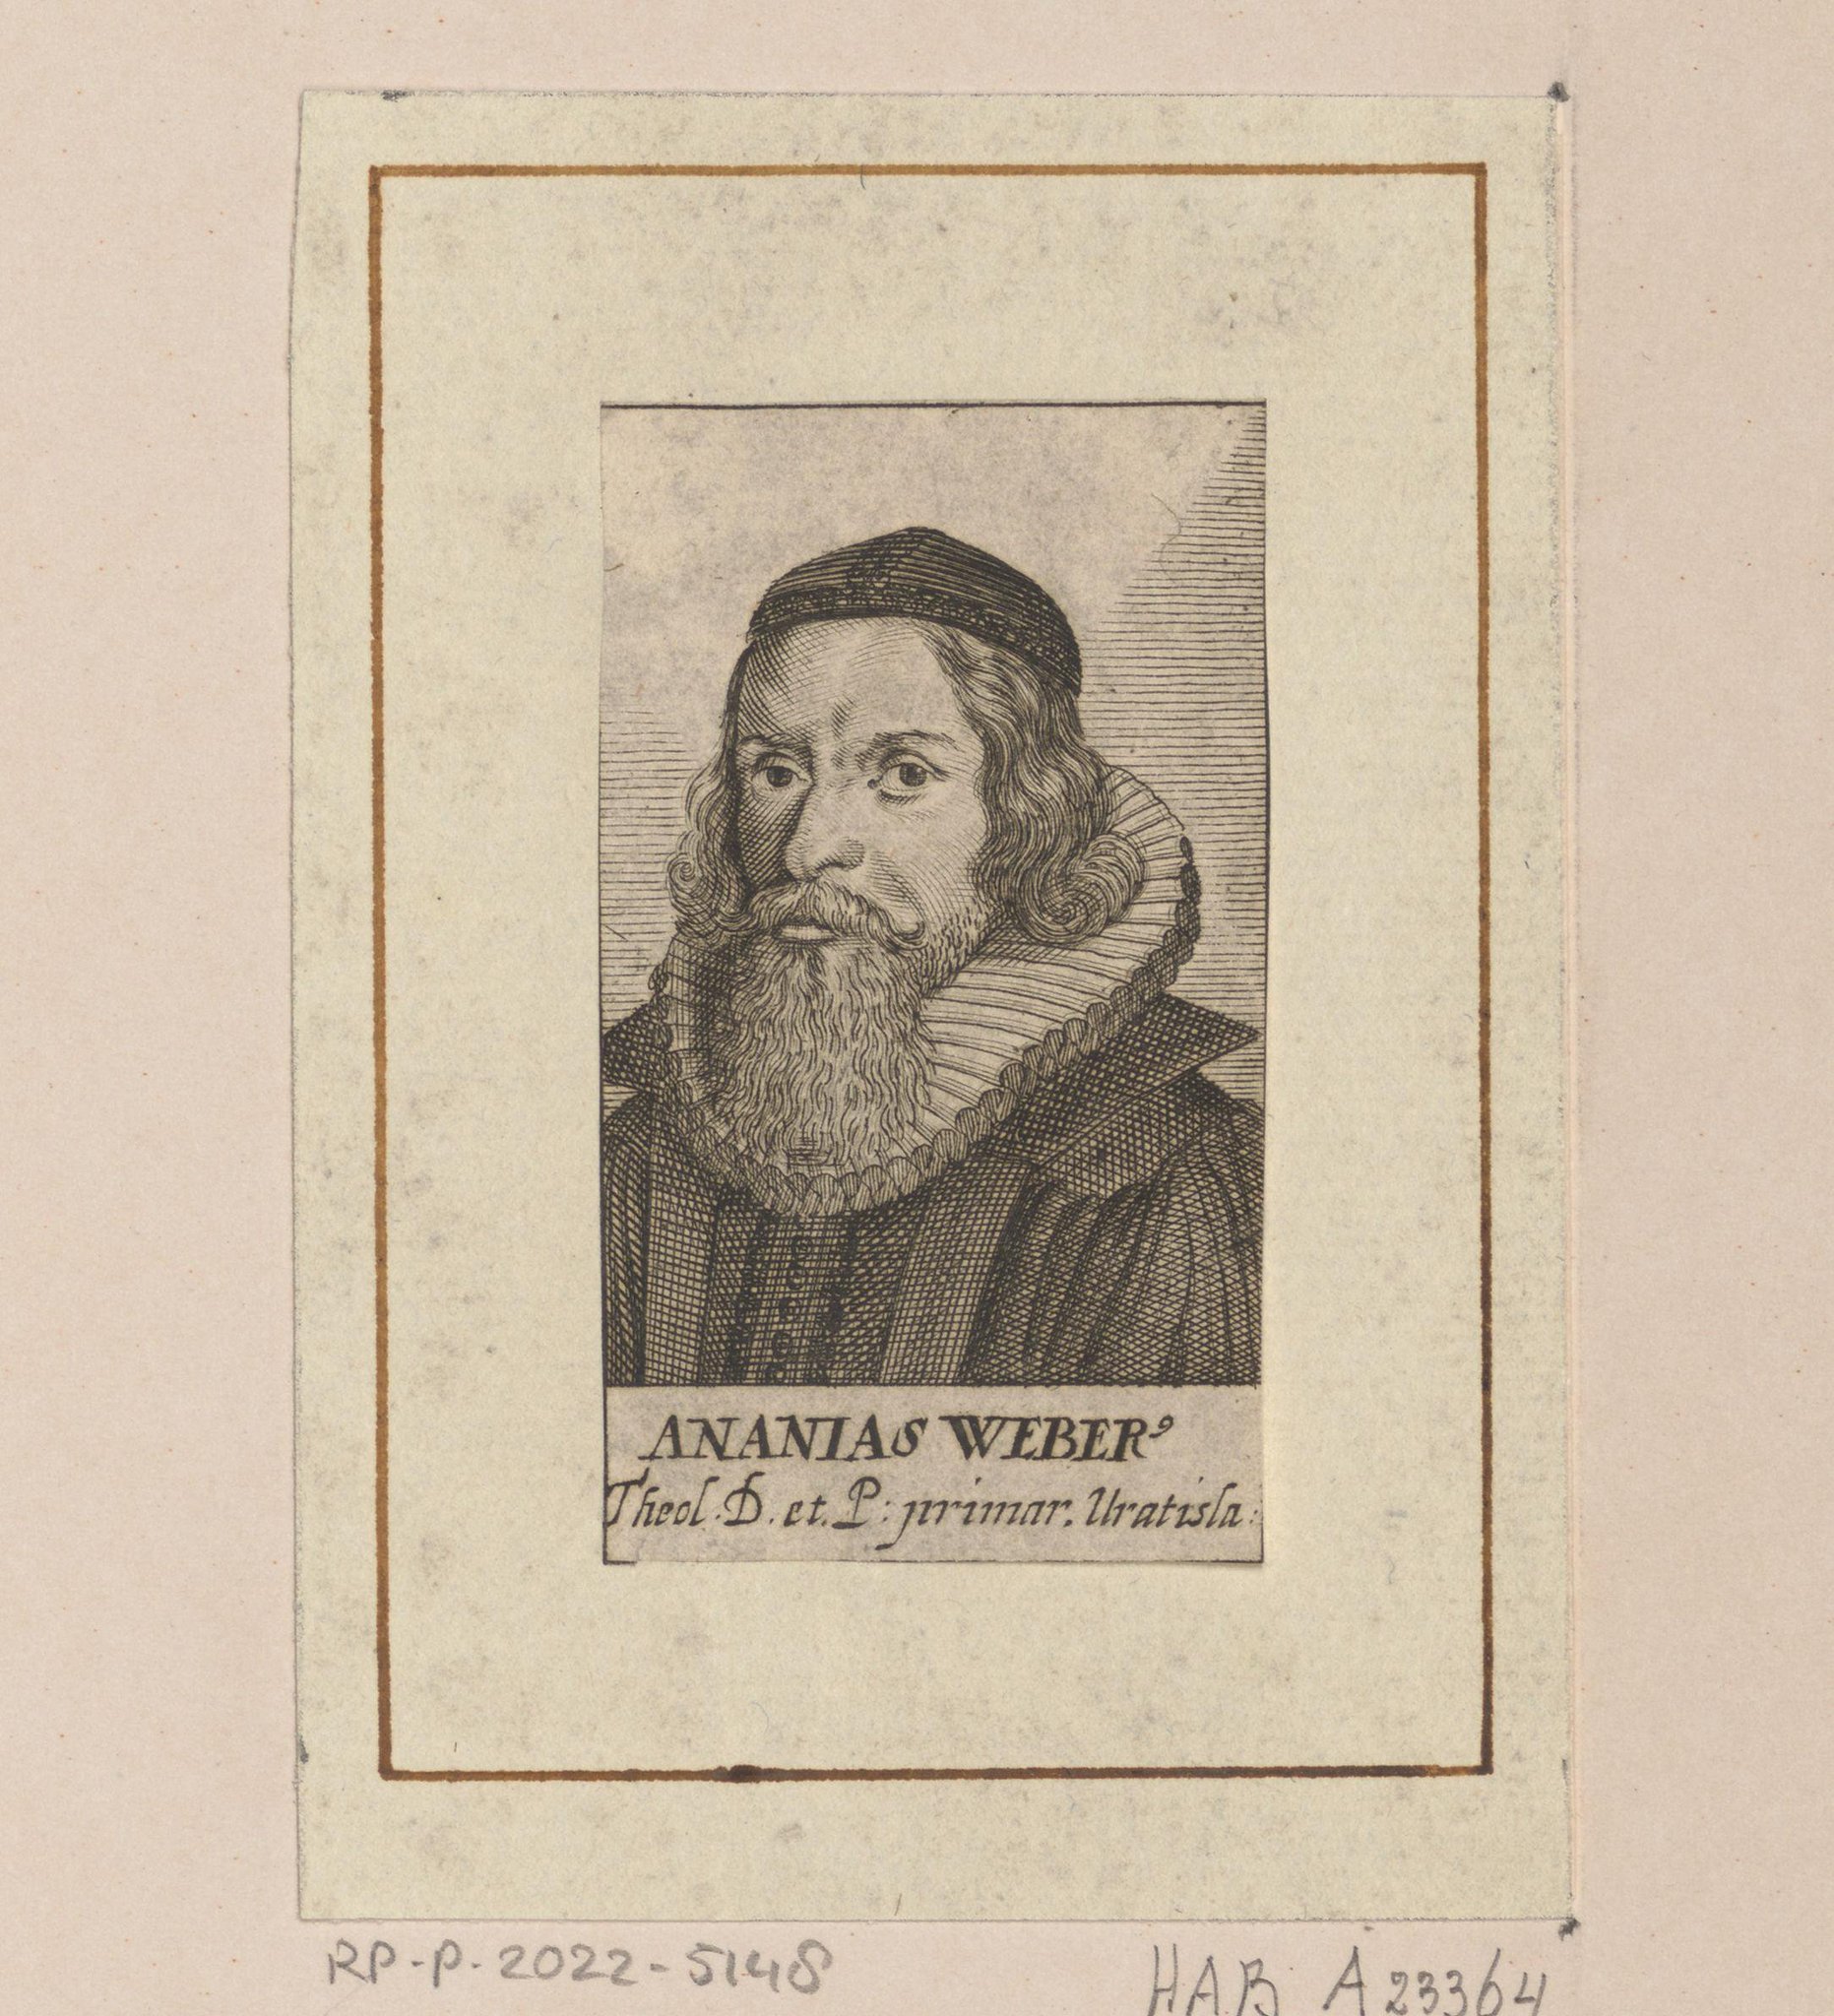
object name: print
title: Portret van Ananias Weber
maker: johann franck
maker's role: print maker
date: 1688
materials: paper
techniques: engraving, etching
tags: theologian, historical persons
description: Prent uit: Freher, Paul. Theatrum virorum eruditione clarorum. Neurenberg: Johann Hoffmann, 1688.